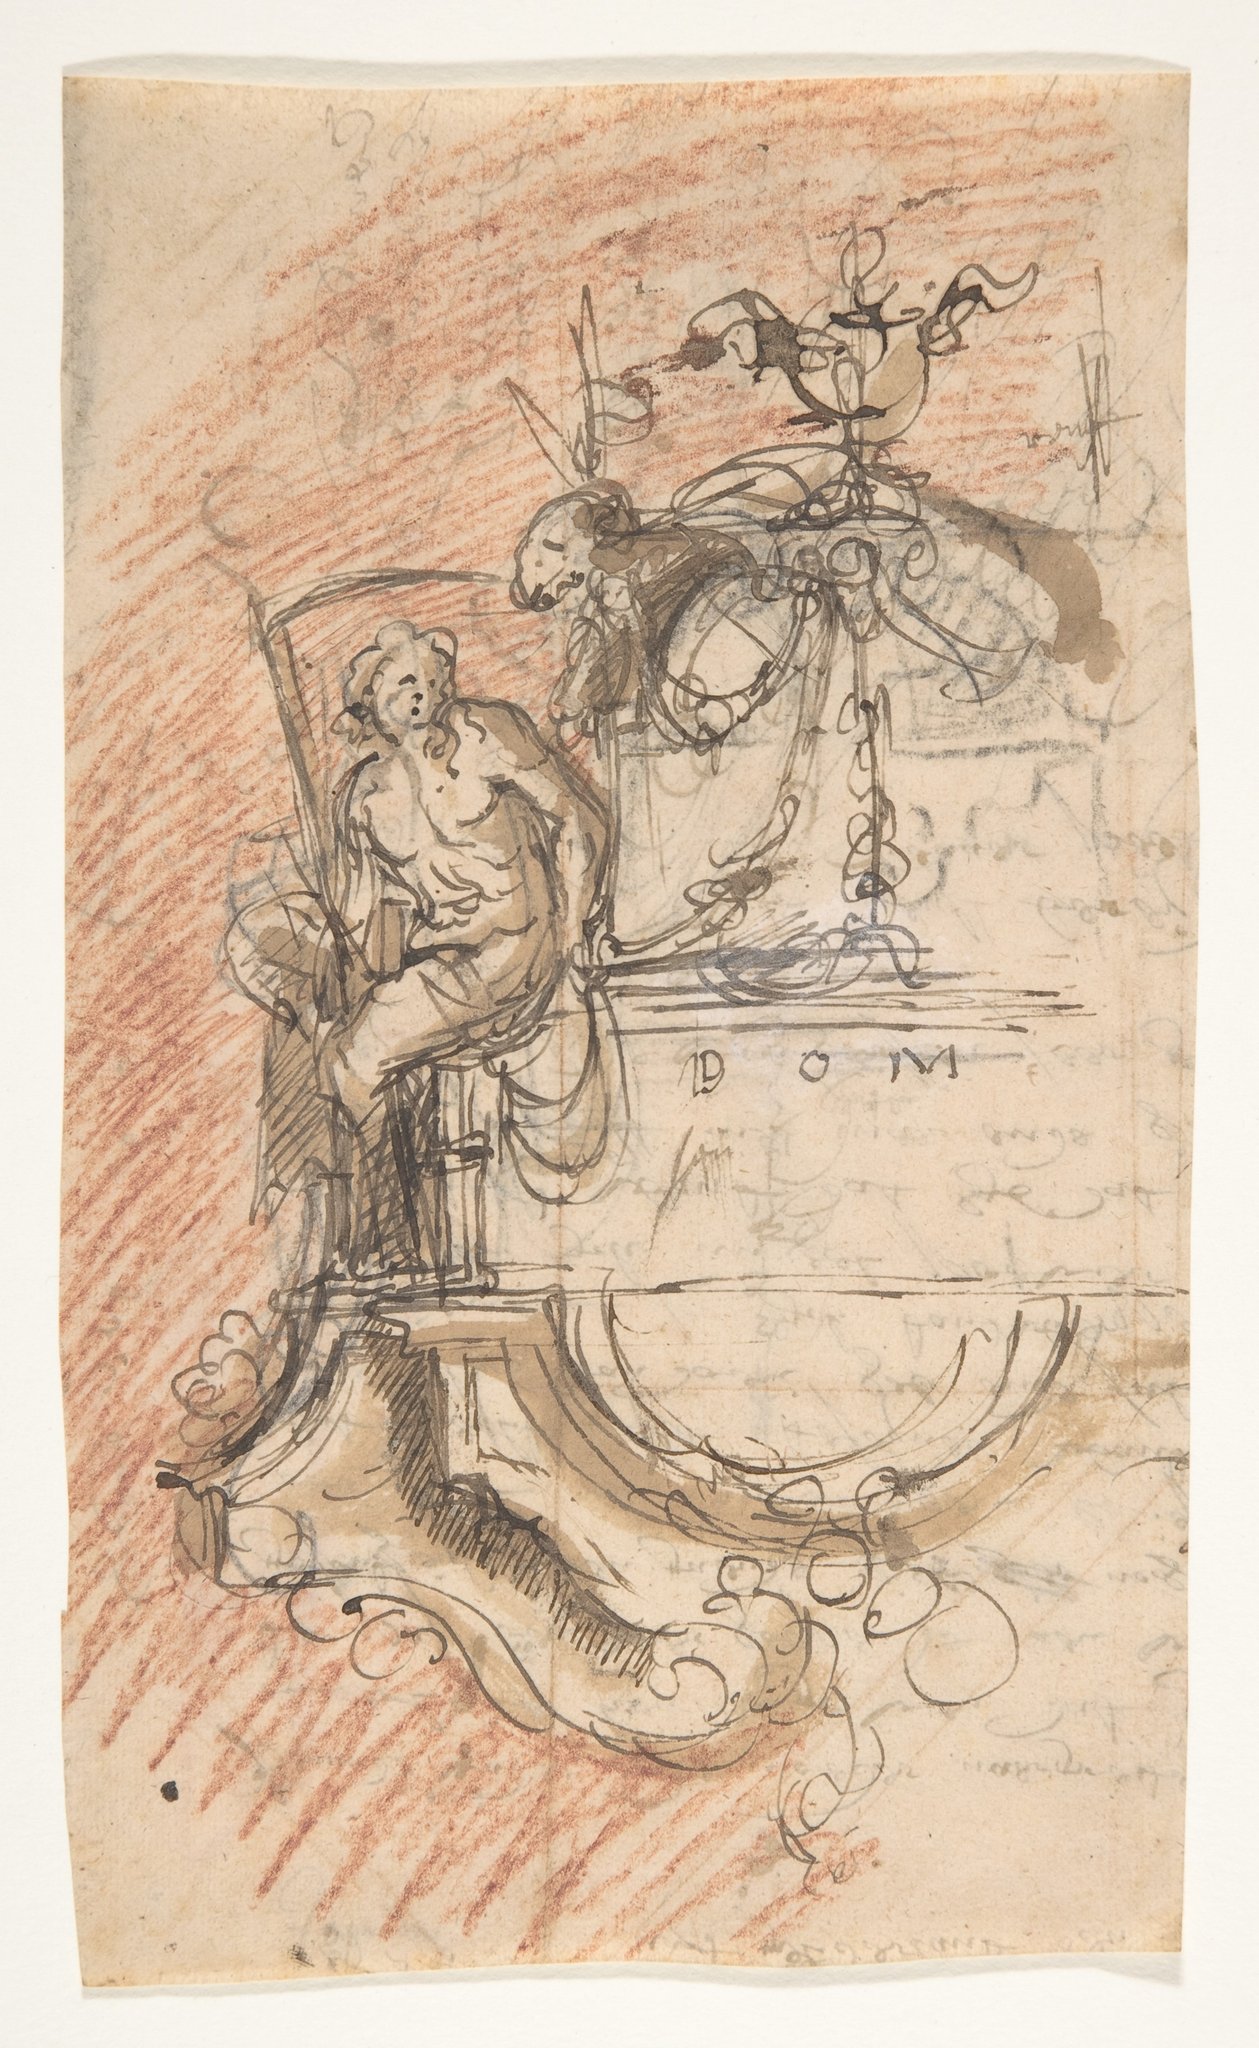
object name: drawing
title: Design for a sepulchral monument with an allegory of Time (recto); Architectural sketch and fragment of a letter (verso)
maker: pieter verbruggen the younger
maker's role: artist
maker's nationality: flemish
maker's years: 1648-1691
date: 1667-1733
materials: chalk, graphite, ink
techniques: pen, wash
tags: human figures